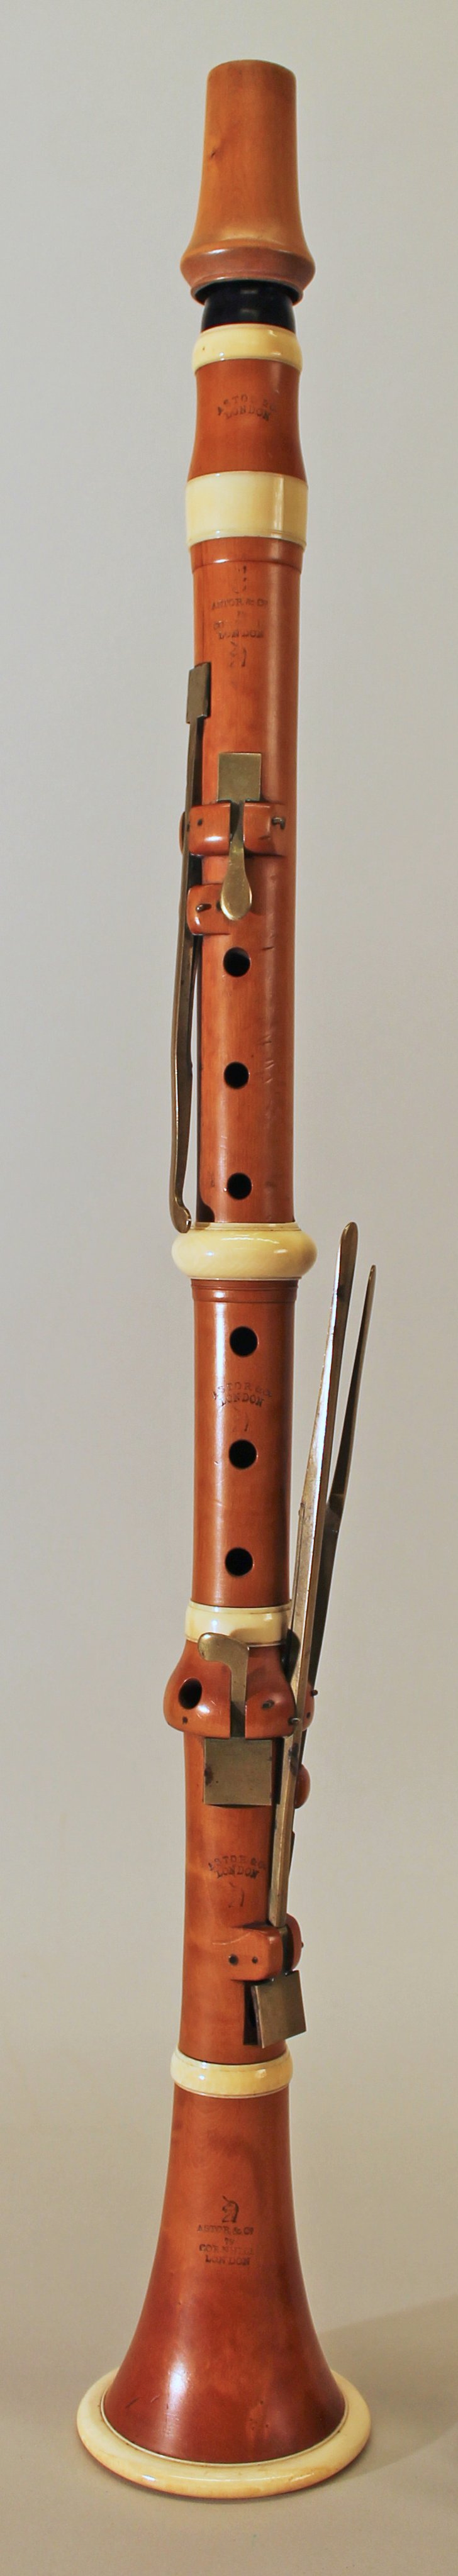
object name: clarinet in c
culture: british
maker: astor & co.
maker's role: maker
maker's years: 1778-1831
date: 1800-1814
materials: wood, brass, ivory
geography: united kingdom